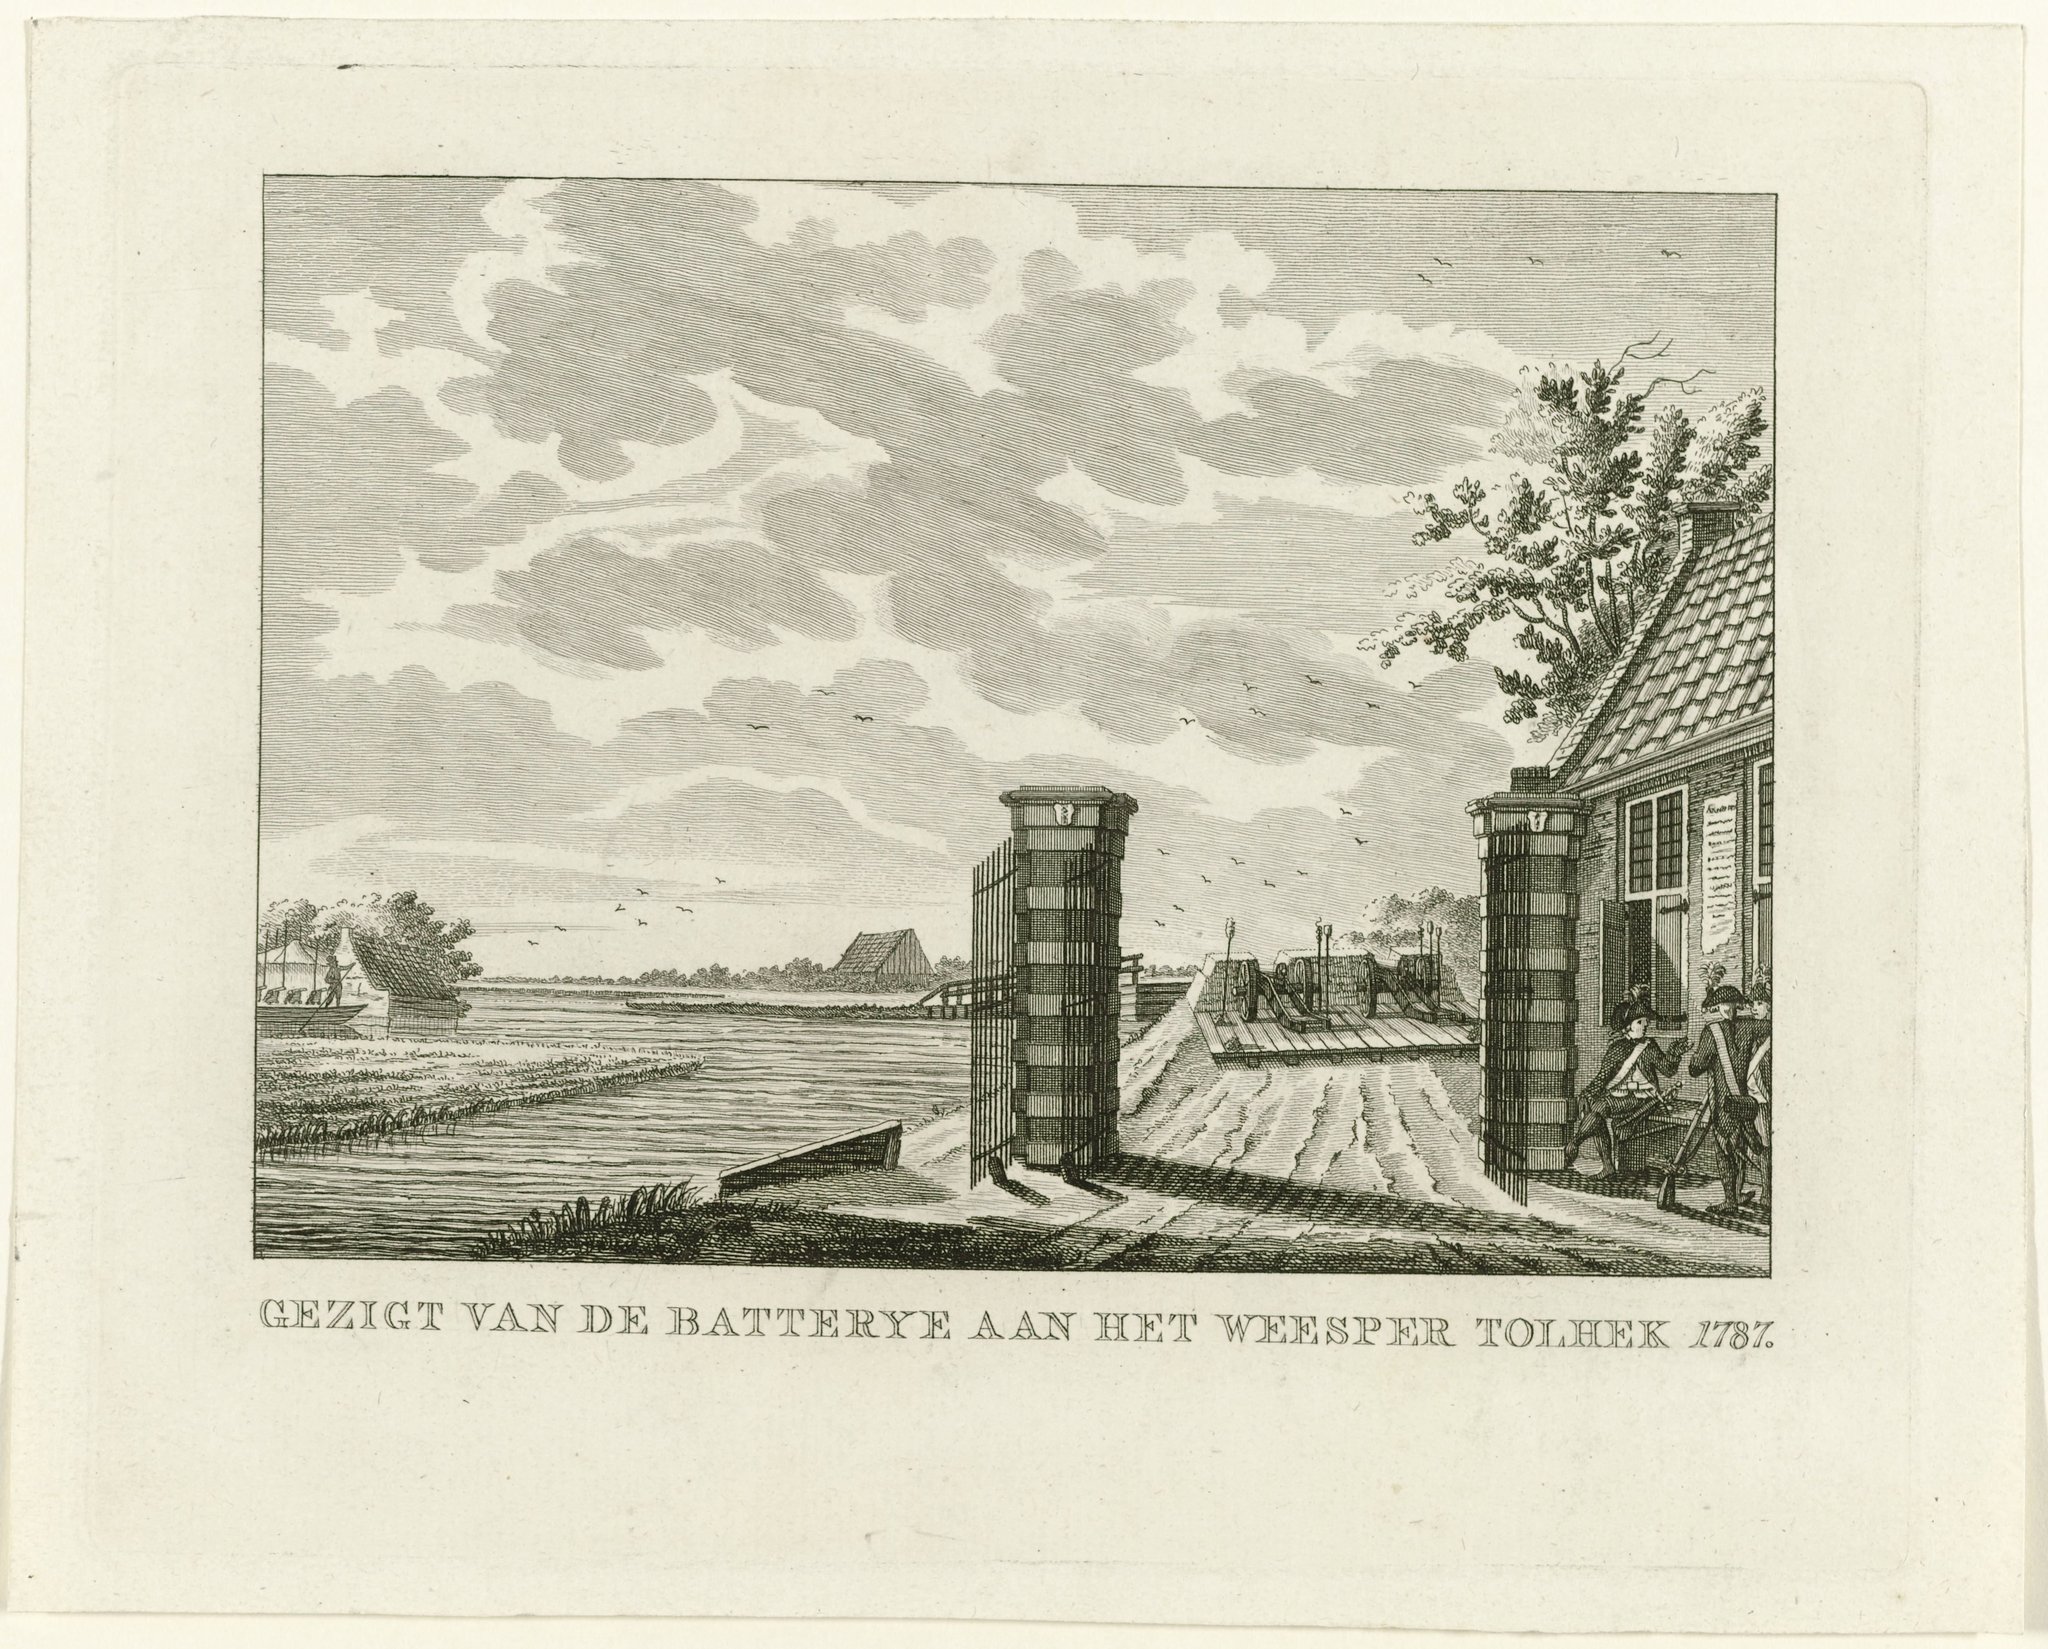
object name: print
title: Gezigt van de batterye aan het Weesper tolhek 1787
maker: Anonymous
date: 1787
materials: paper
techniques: etching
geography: northern netherlands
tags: defence of fortification or city, defensive measures (military)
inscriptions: collector's mark: Lugt 2228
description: Batterij aan het Weesper tolhek, aan de Weespertrekvaart op het Zandpad naar Weesp. Onderdeel van een serie van veertien platen van de verdedigingen aangelegd door de patriotten rondom Amsterdam ten tijde van de inval van de Pruisische troepen in september 1787.